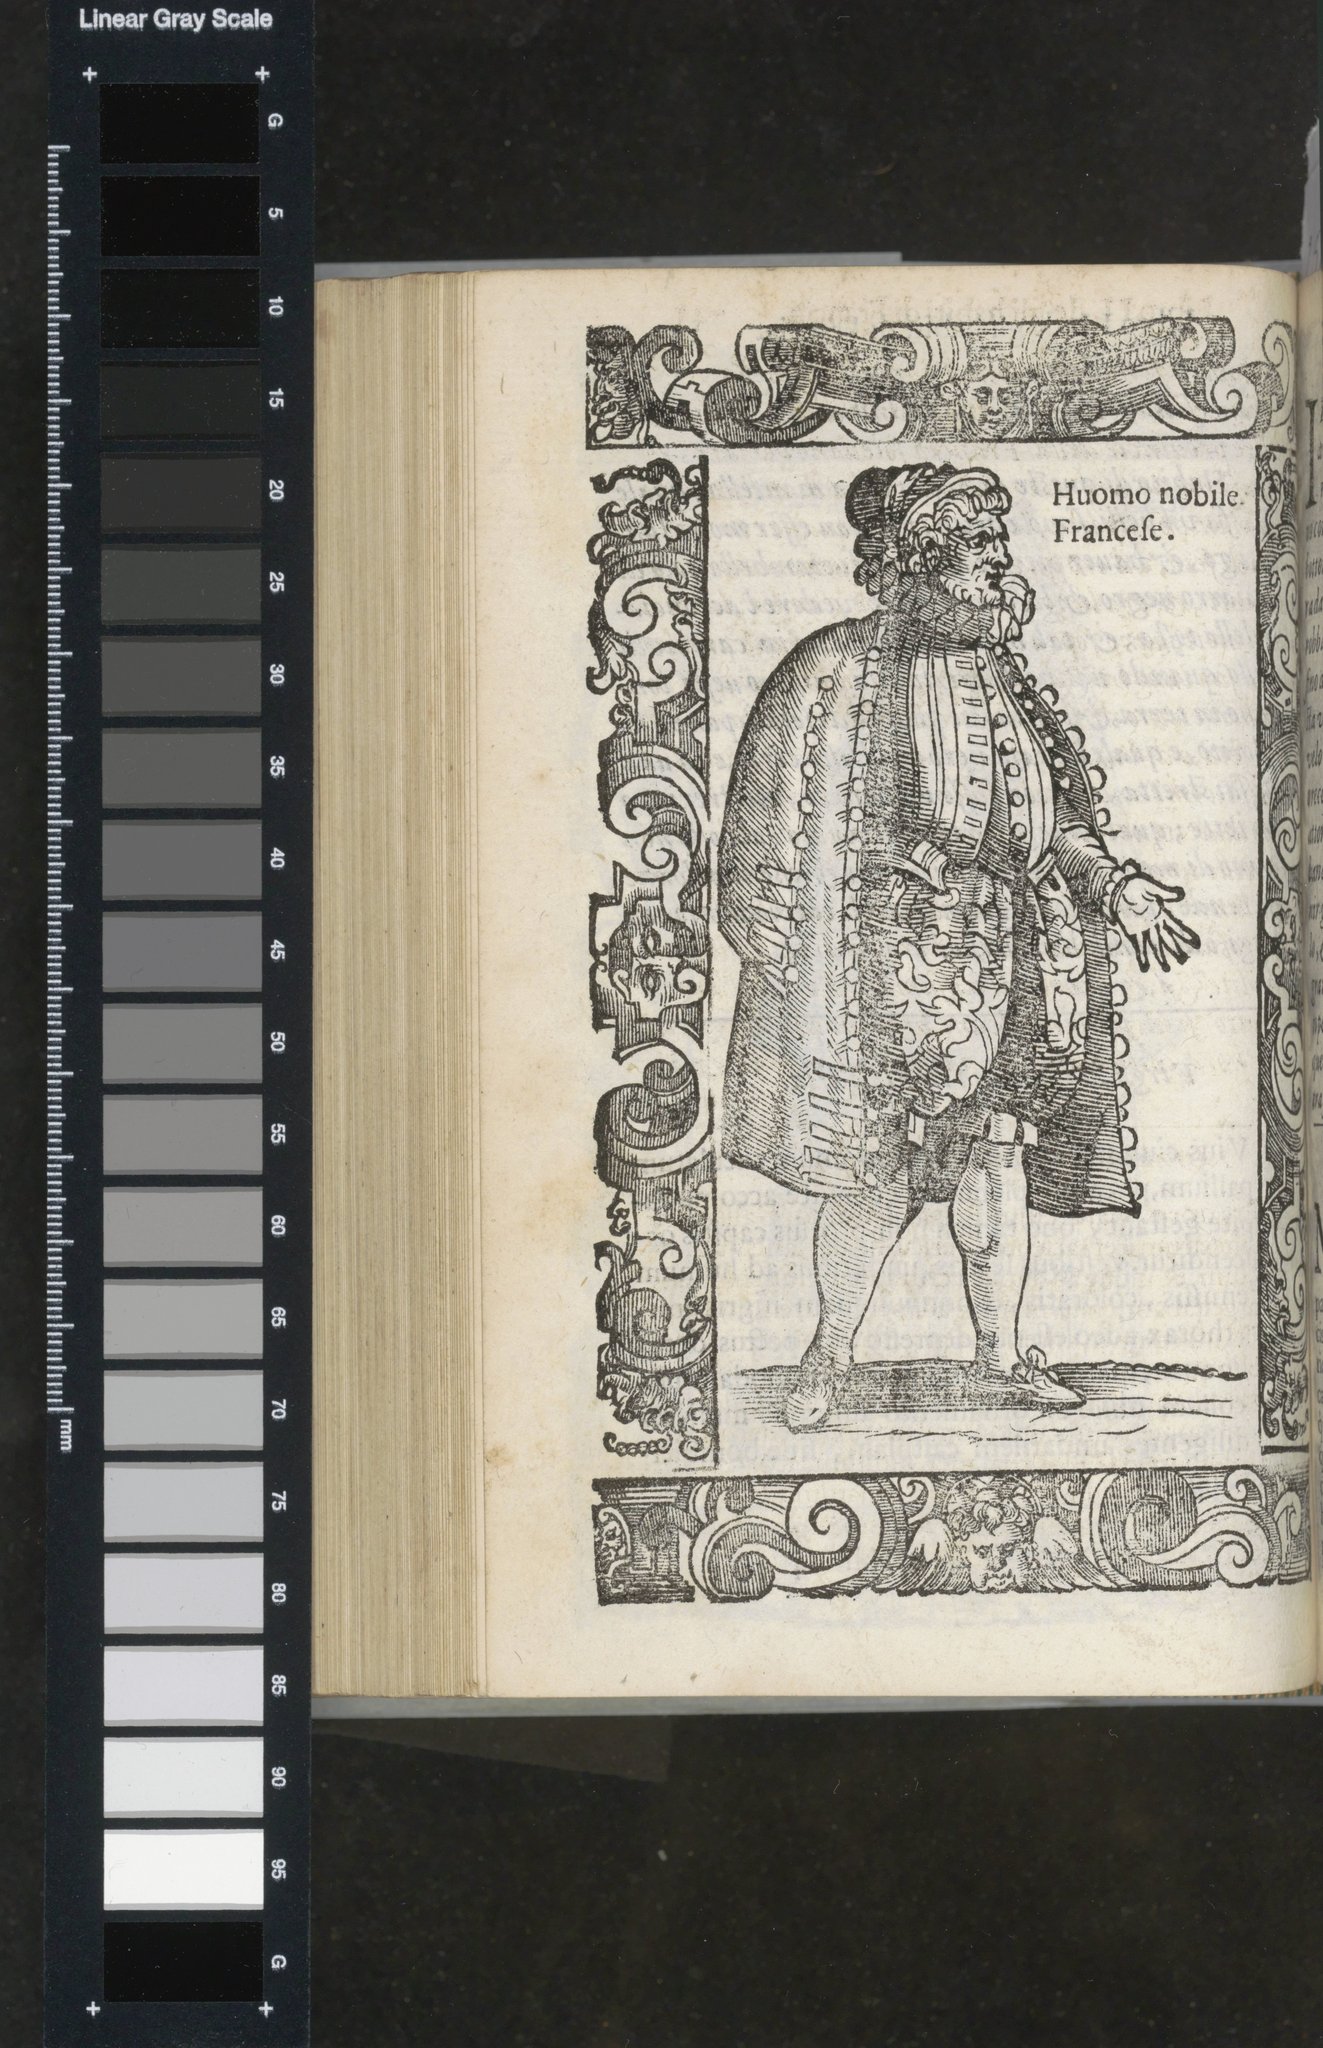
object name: costume print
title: Habiti antichi, et moderni di tutto il mondo...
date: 1598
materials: paper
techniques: woodcut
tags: fashion plates